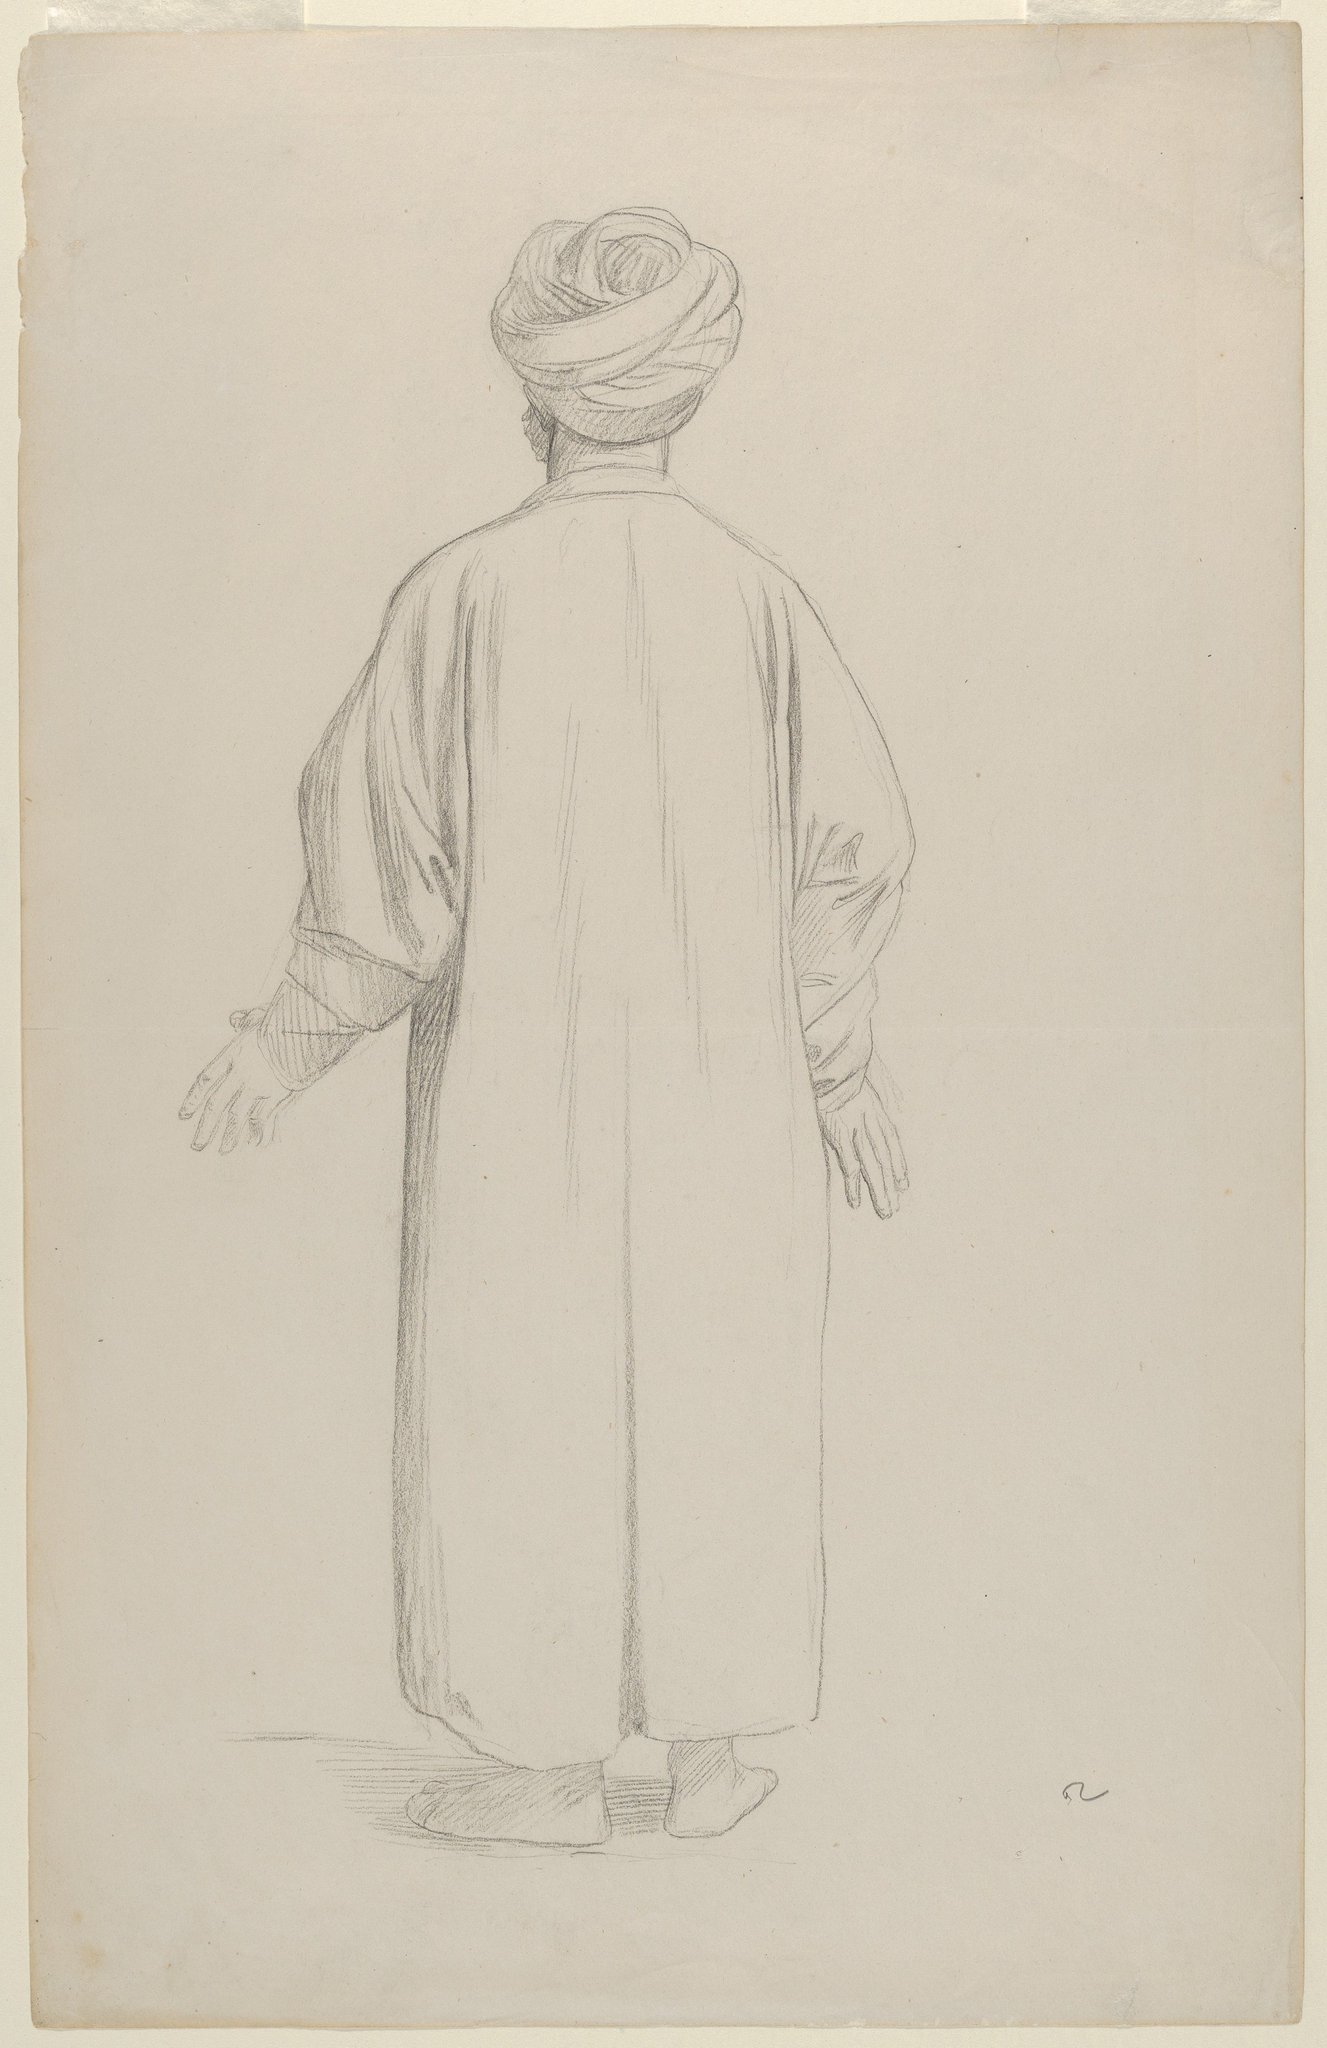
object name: drawing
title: A Muslim Preparing for Prayer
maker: jean-léon gérôme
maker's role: artist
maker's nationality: french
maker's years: 1824-1904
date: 1862-1867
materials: chalk, paper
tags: men